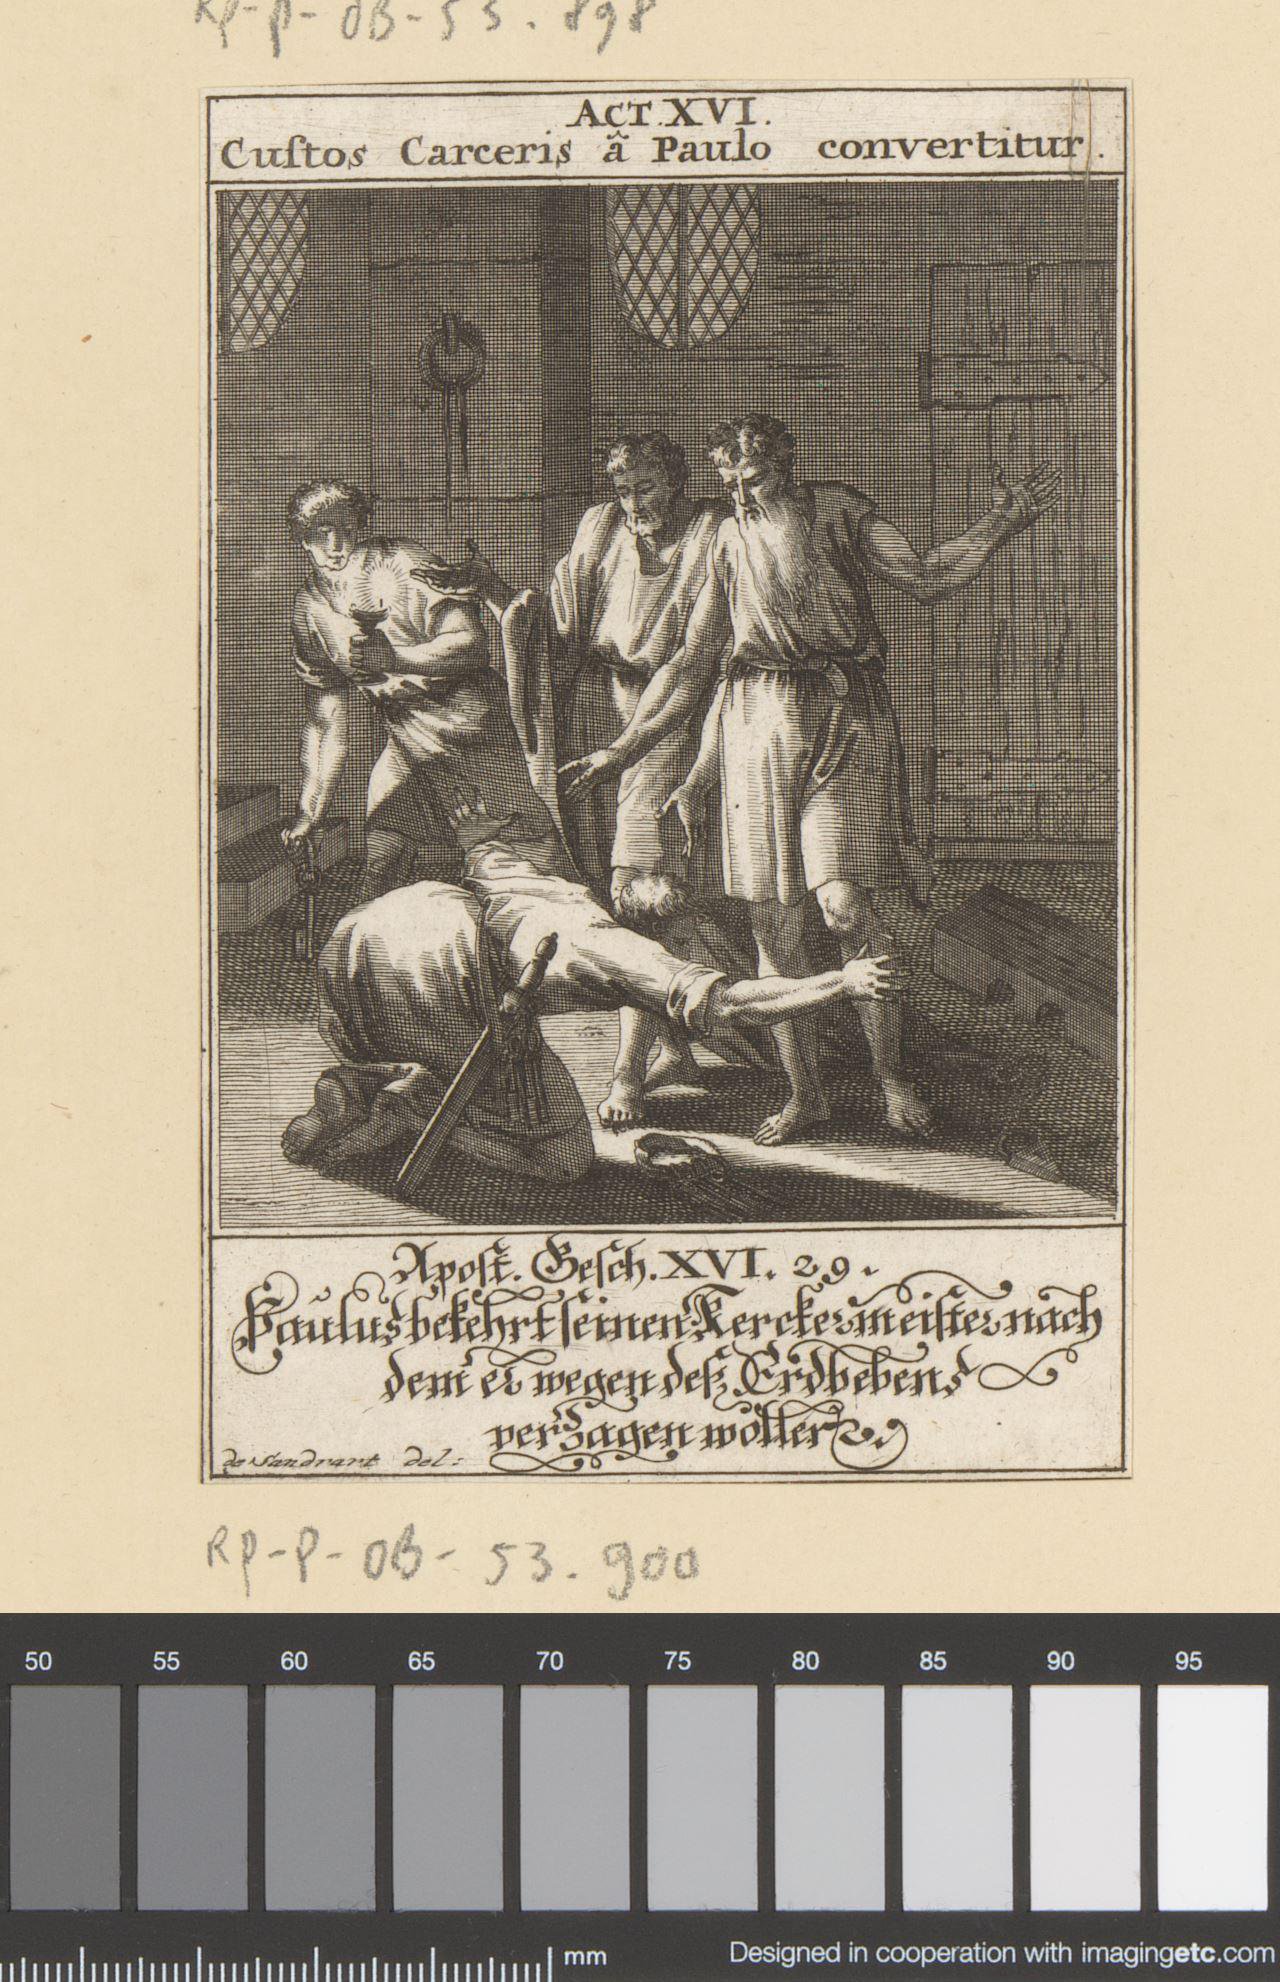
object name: print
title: Apostel Paulus en Silas bekeren de gevangenbewaarder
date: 1697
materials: paper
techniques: etching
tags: paul and silas teach the word of god to the warder, who kneels before them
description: Prent ook gebruikt in: Biblia ectypa : Bildnussen auss Heiliger Schrifft. Regensburg: Chr. Wiegel, 1697.